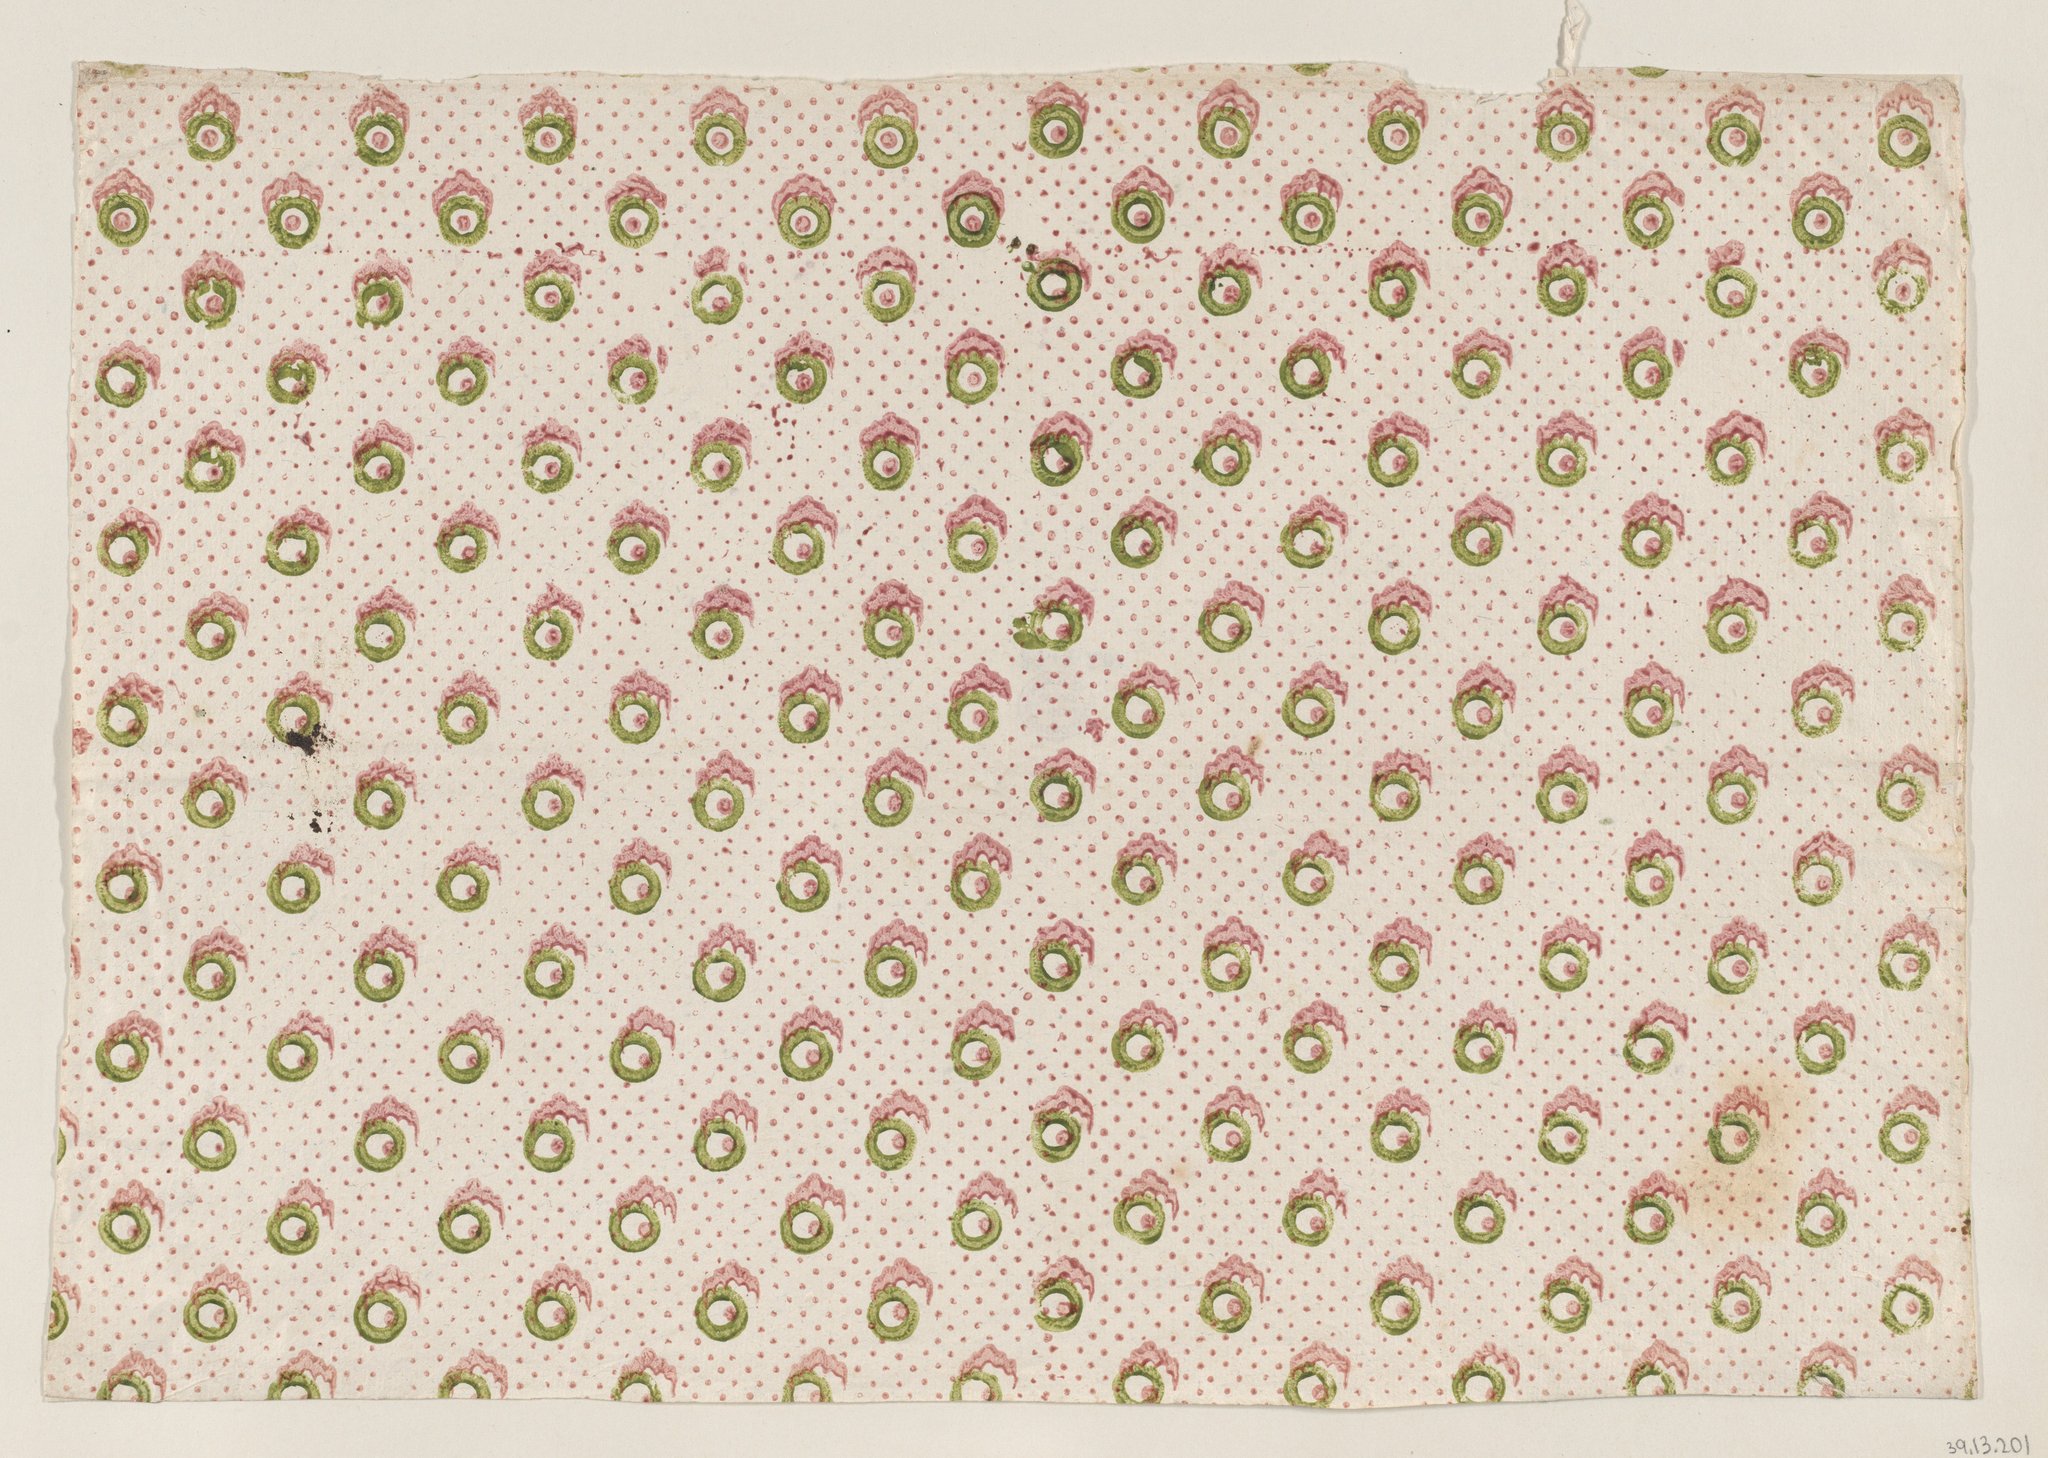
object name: print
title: Sheet with overall dot and abstract pattern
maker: Anonymous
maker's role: artist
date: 1801-1900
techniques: relief print